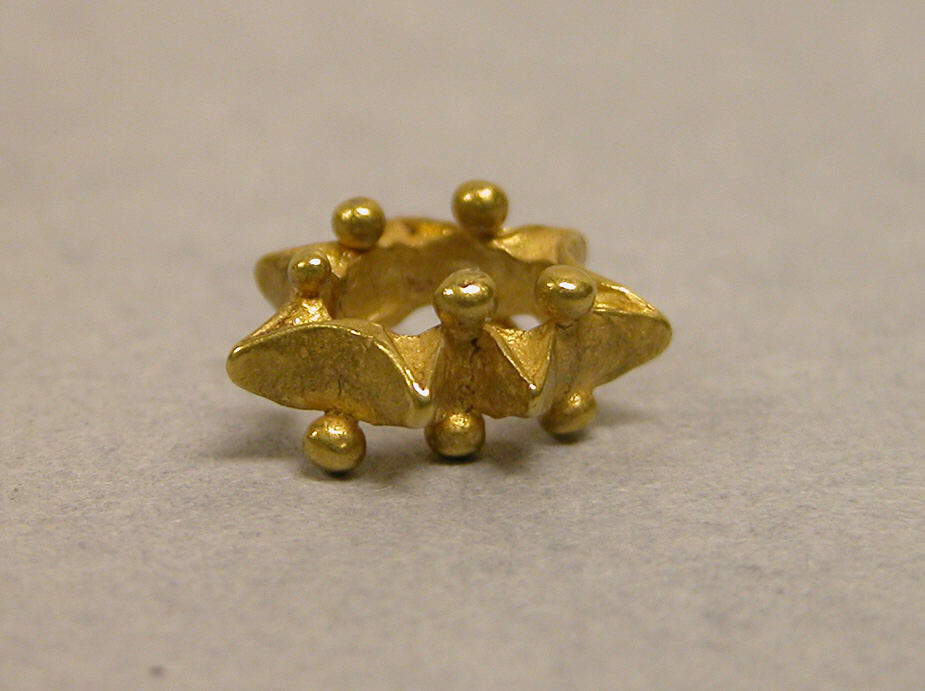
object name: pair of earring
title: Pair of Earrings with Granulation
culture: indonesian, central java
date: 701-1200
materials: gold